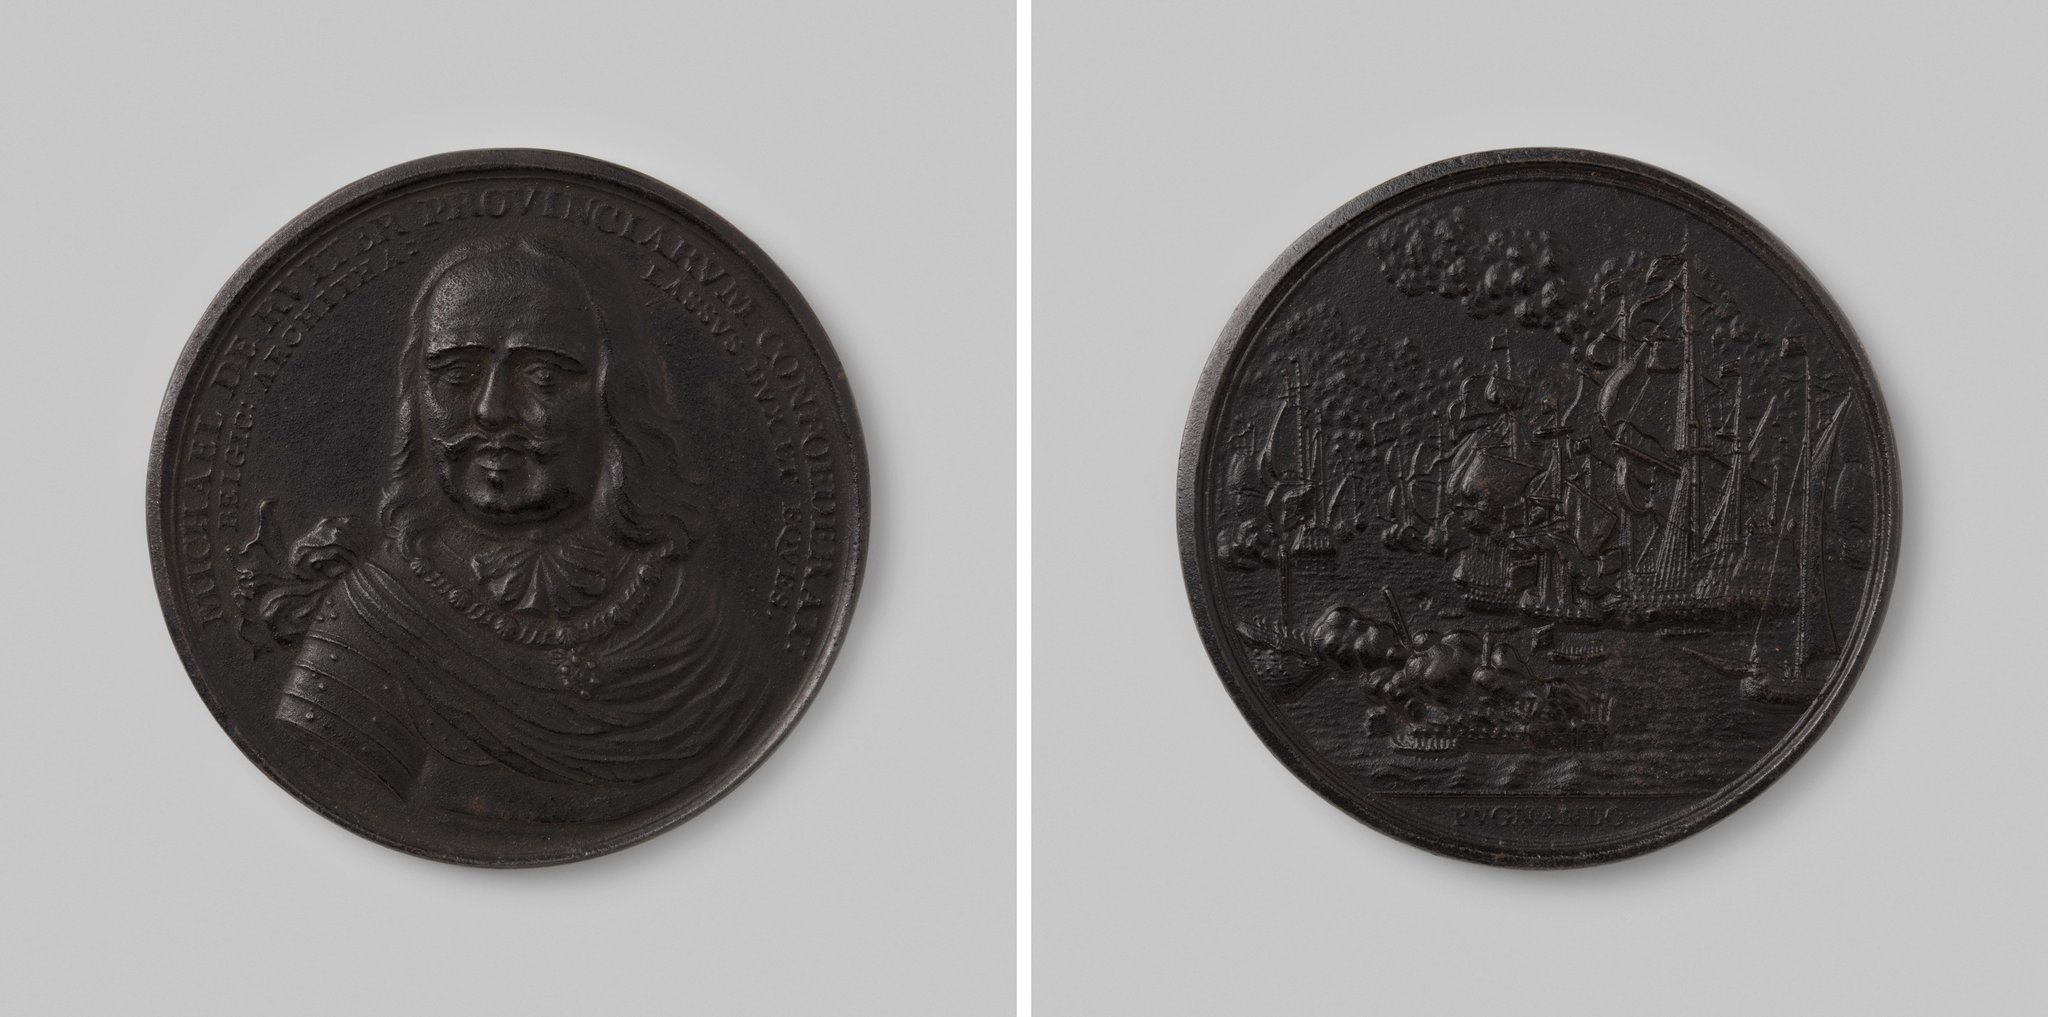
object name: history medal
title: Overlijden van Michiel Adriaanszoon de Ruyter in de Zeeslag bij Sicilië 1676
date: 1825-1850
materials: iron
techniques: casting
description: Gegoten ijzeren penning, op de voorzijde het borstbeeld van De Ruyter half naar links, met omschrift, op de keerzijde is de zeeslag afgebeeld, in afsnede PVGNANDO.